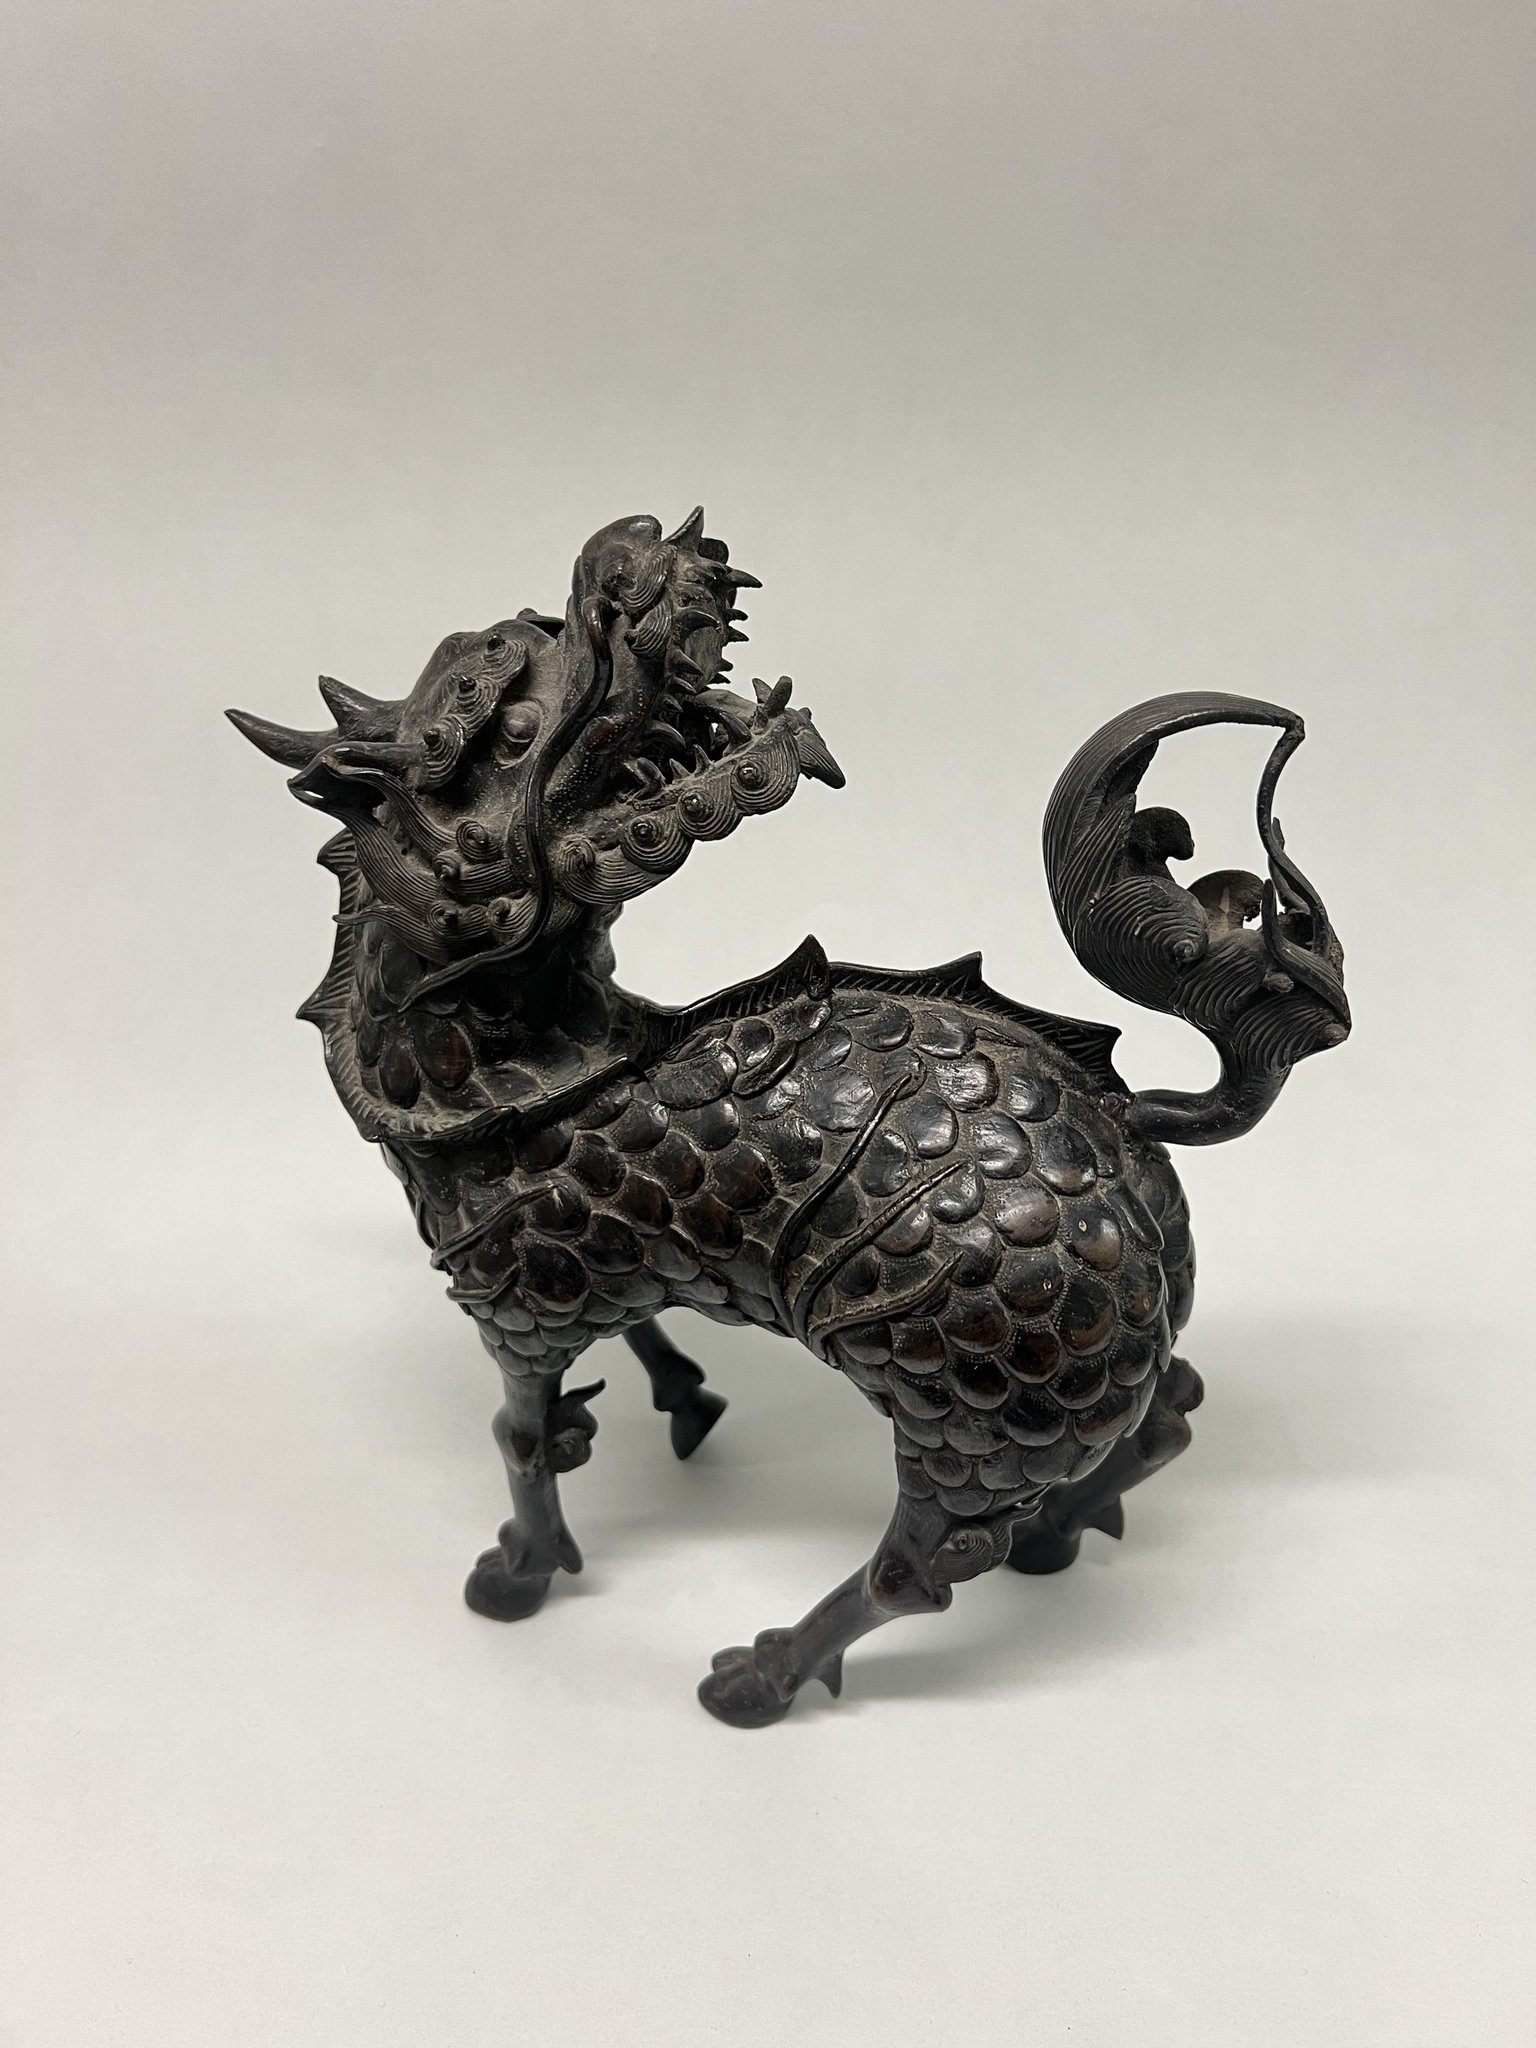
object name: incense burner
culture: chinese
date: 1500-1700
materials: bronze